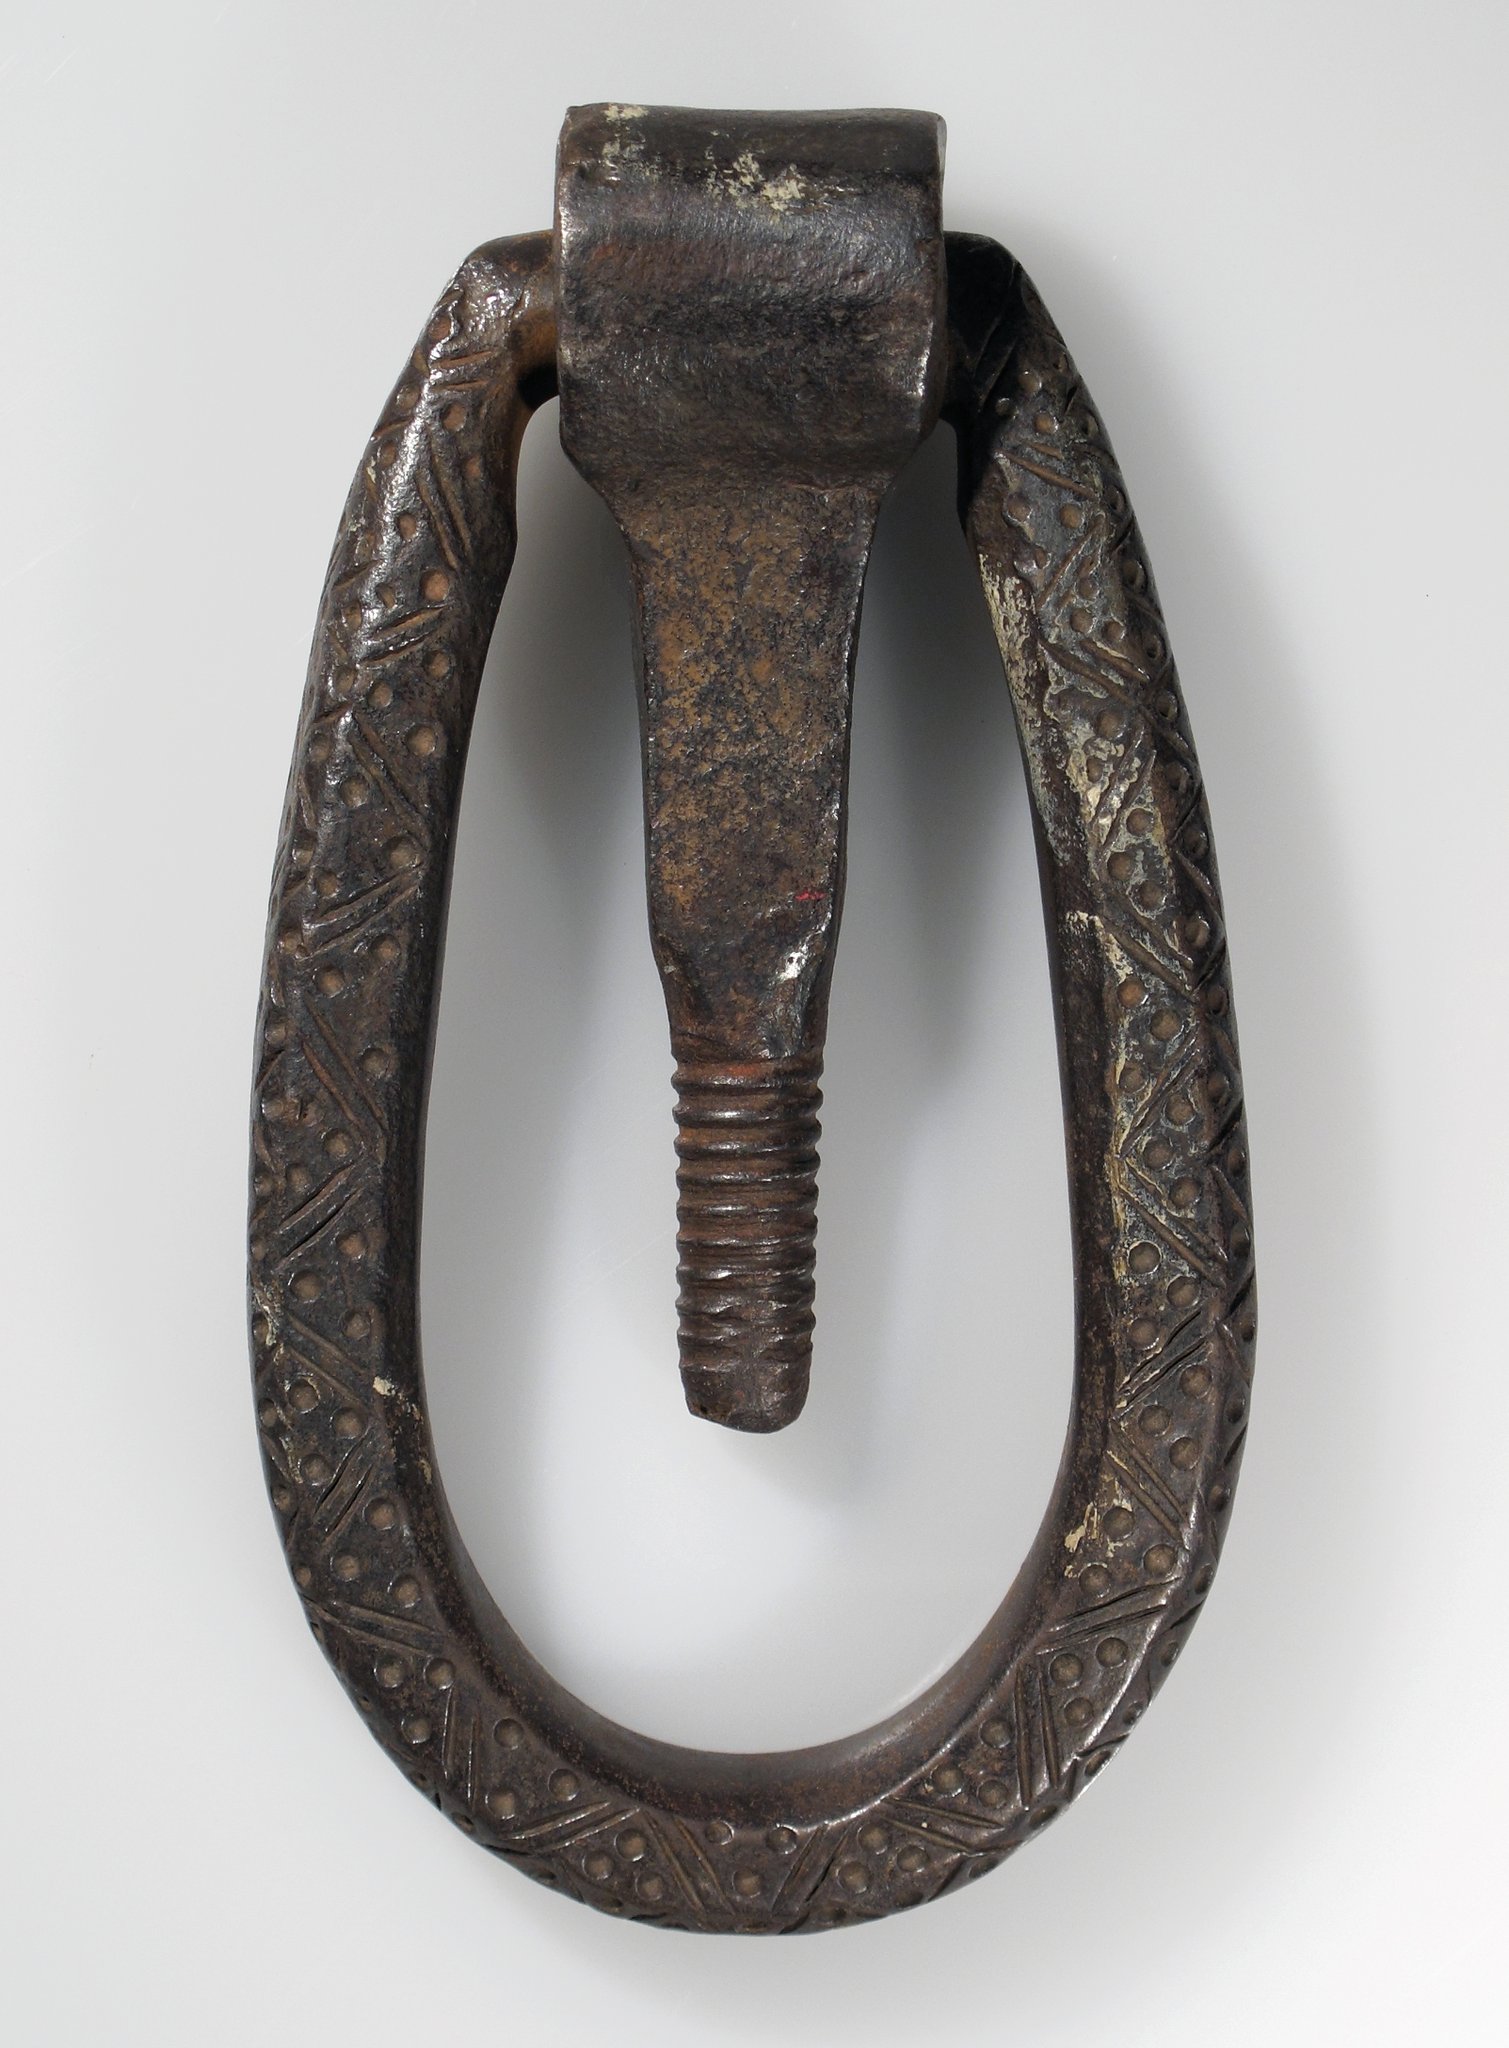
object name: door knocker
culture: european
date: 1401-1600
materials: iron